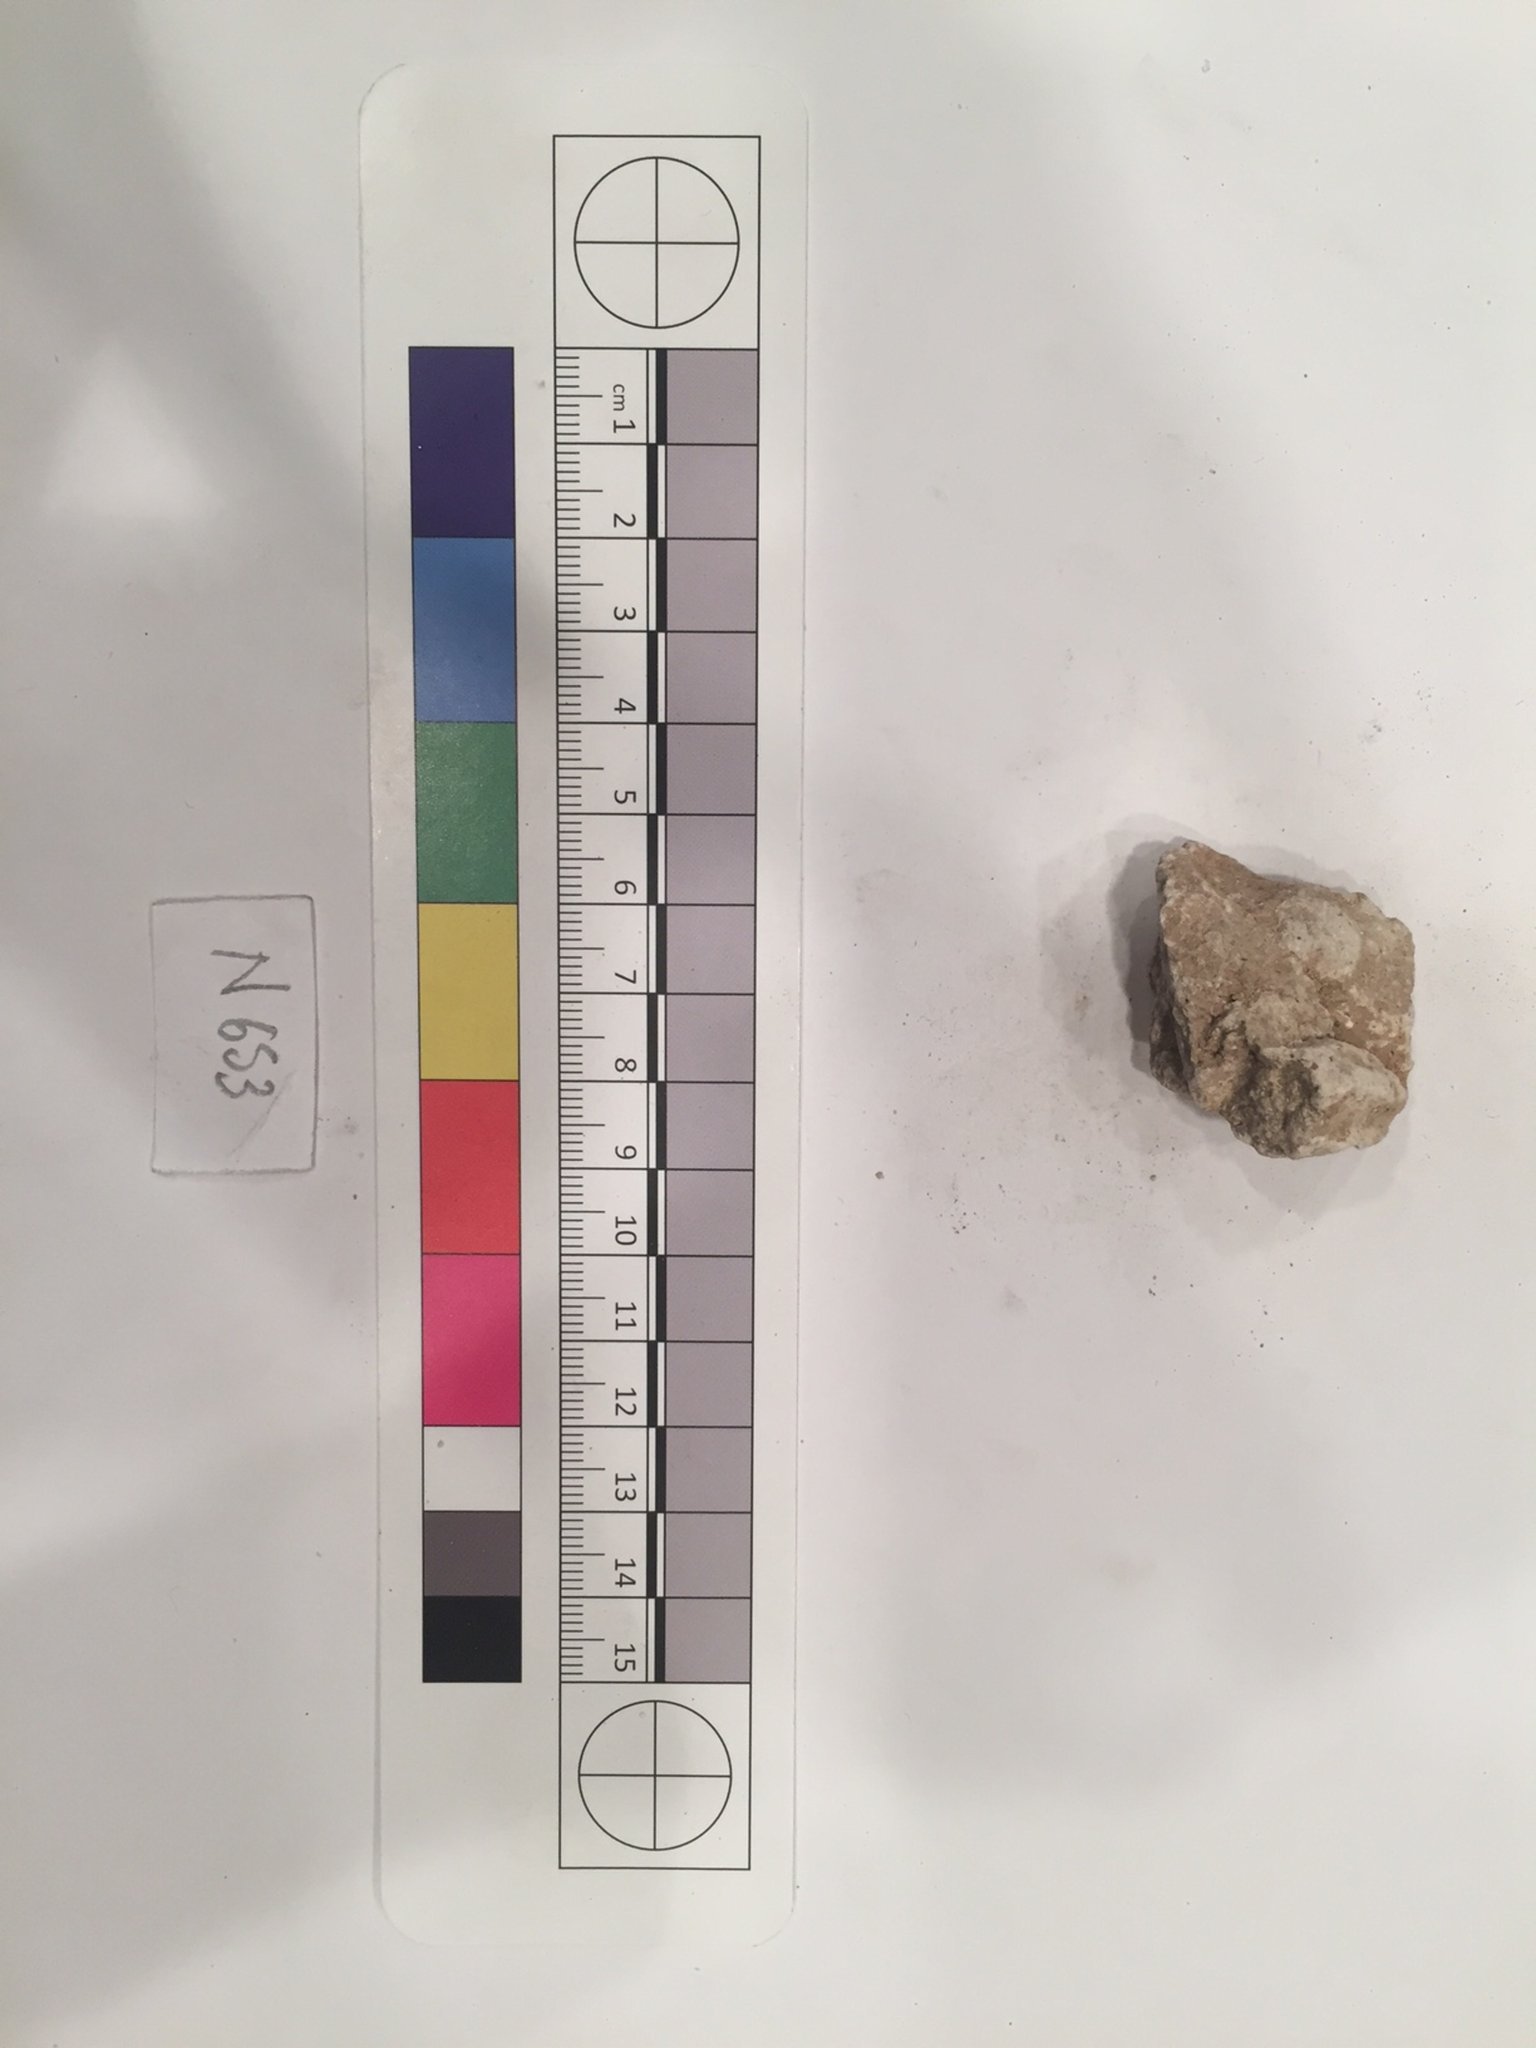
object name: fragment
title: Stucco Fragment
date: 701-1200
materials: plaster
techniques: carving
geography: iran